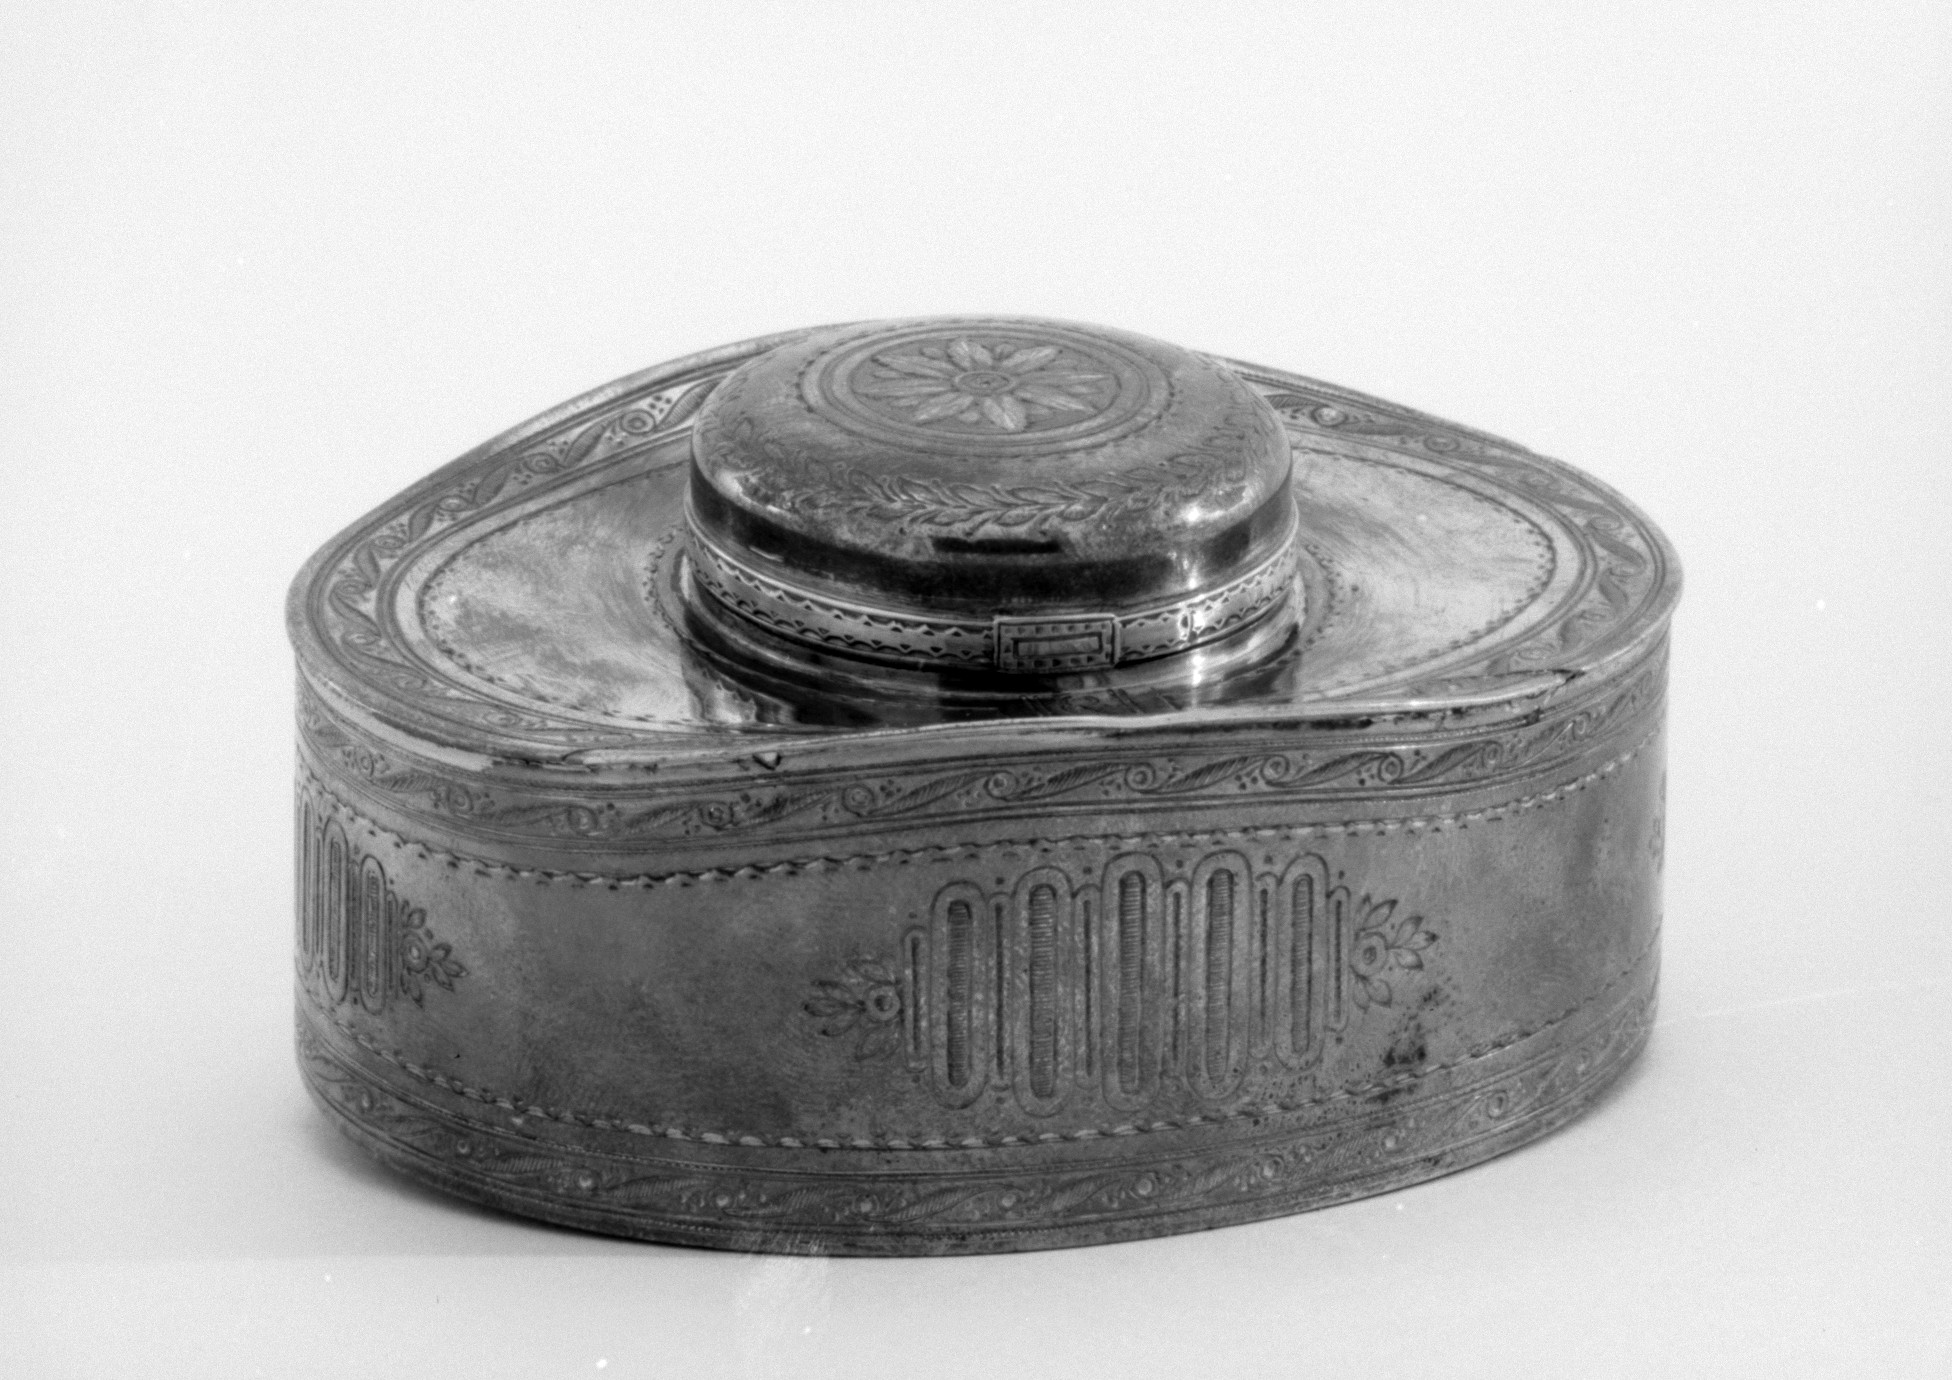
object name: snuffbox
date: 1701-1800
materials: brass, copper